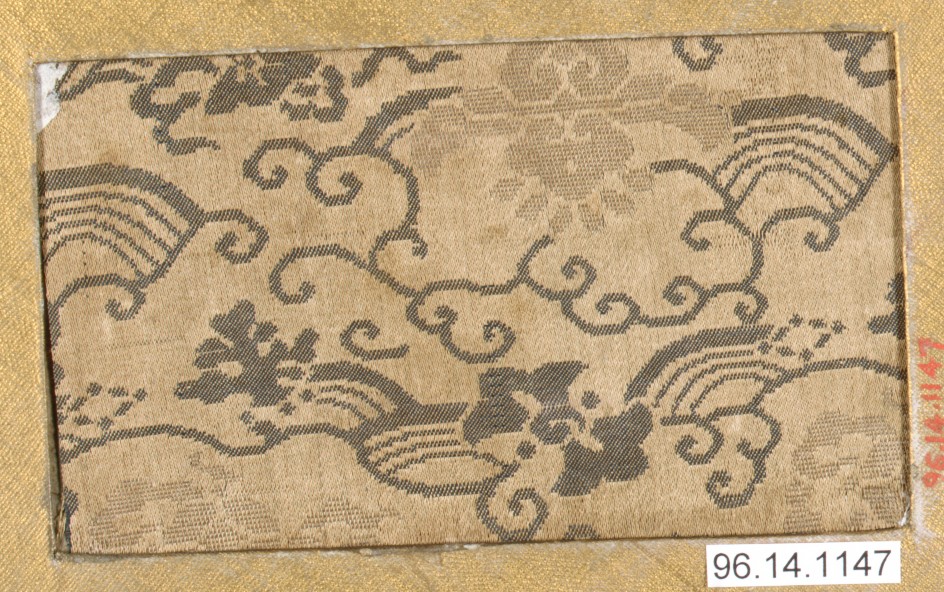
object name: piece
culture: japanese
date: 1701-1900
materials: silk